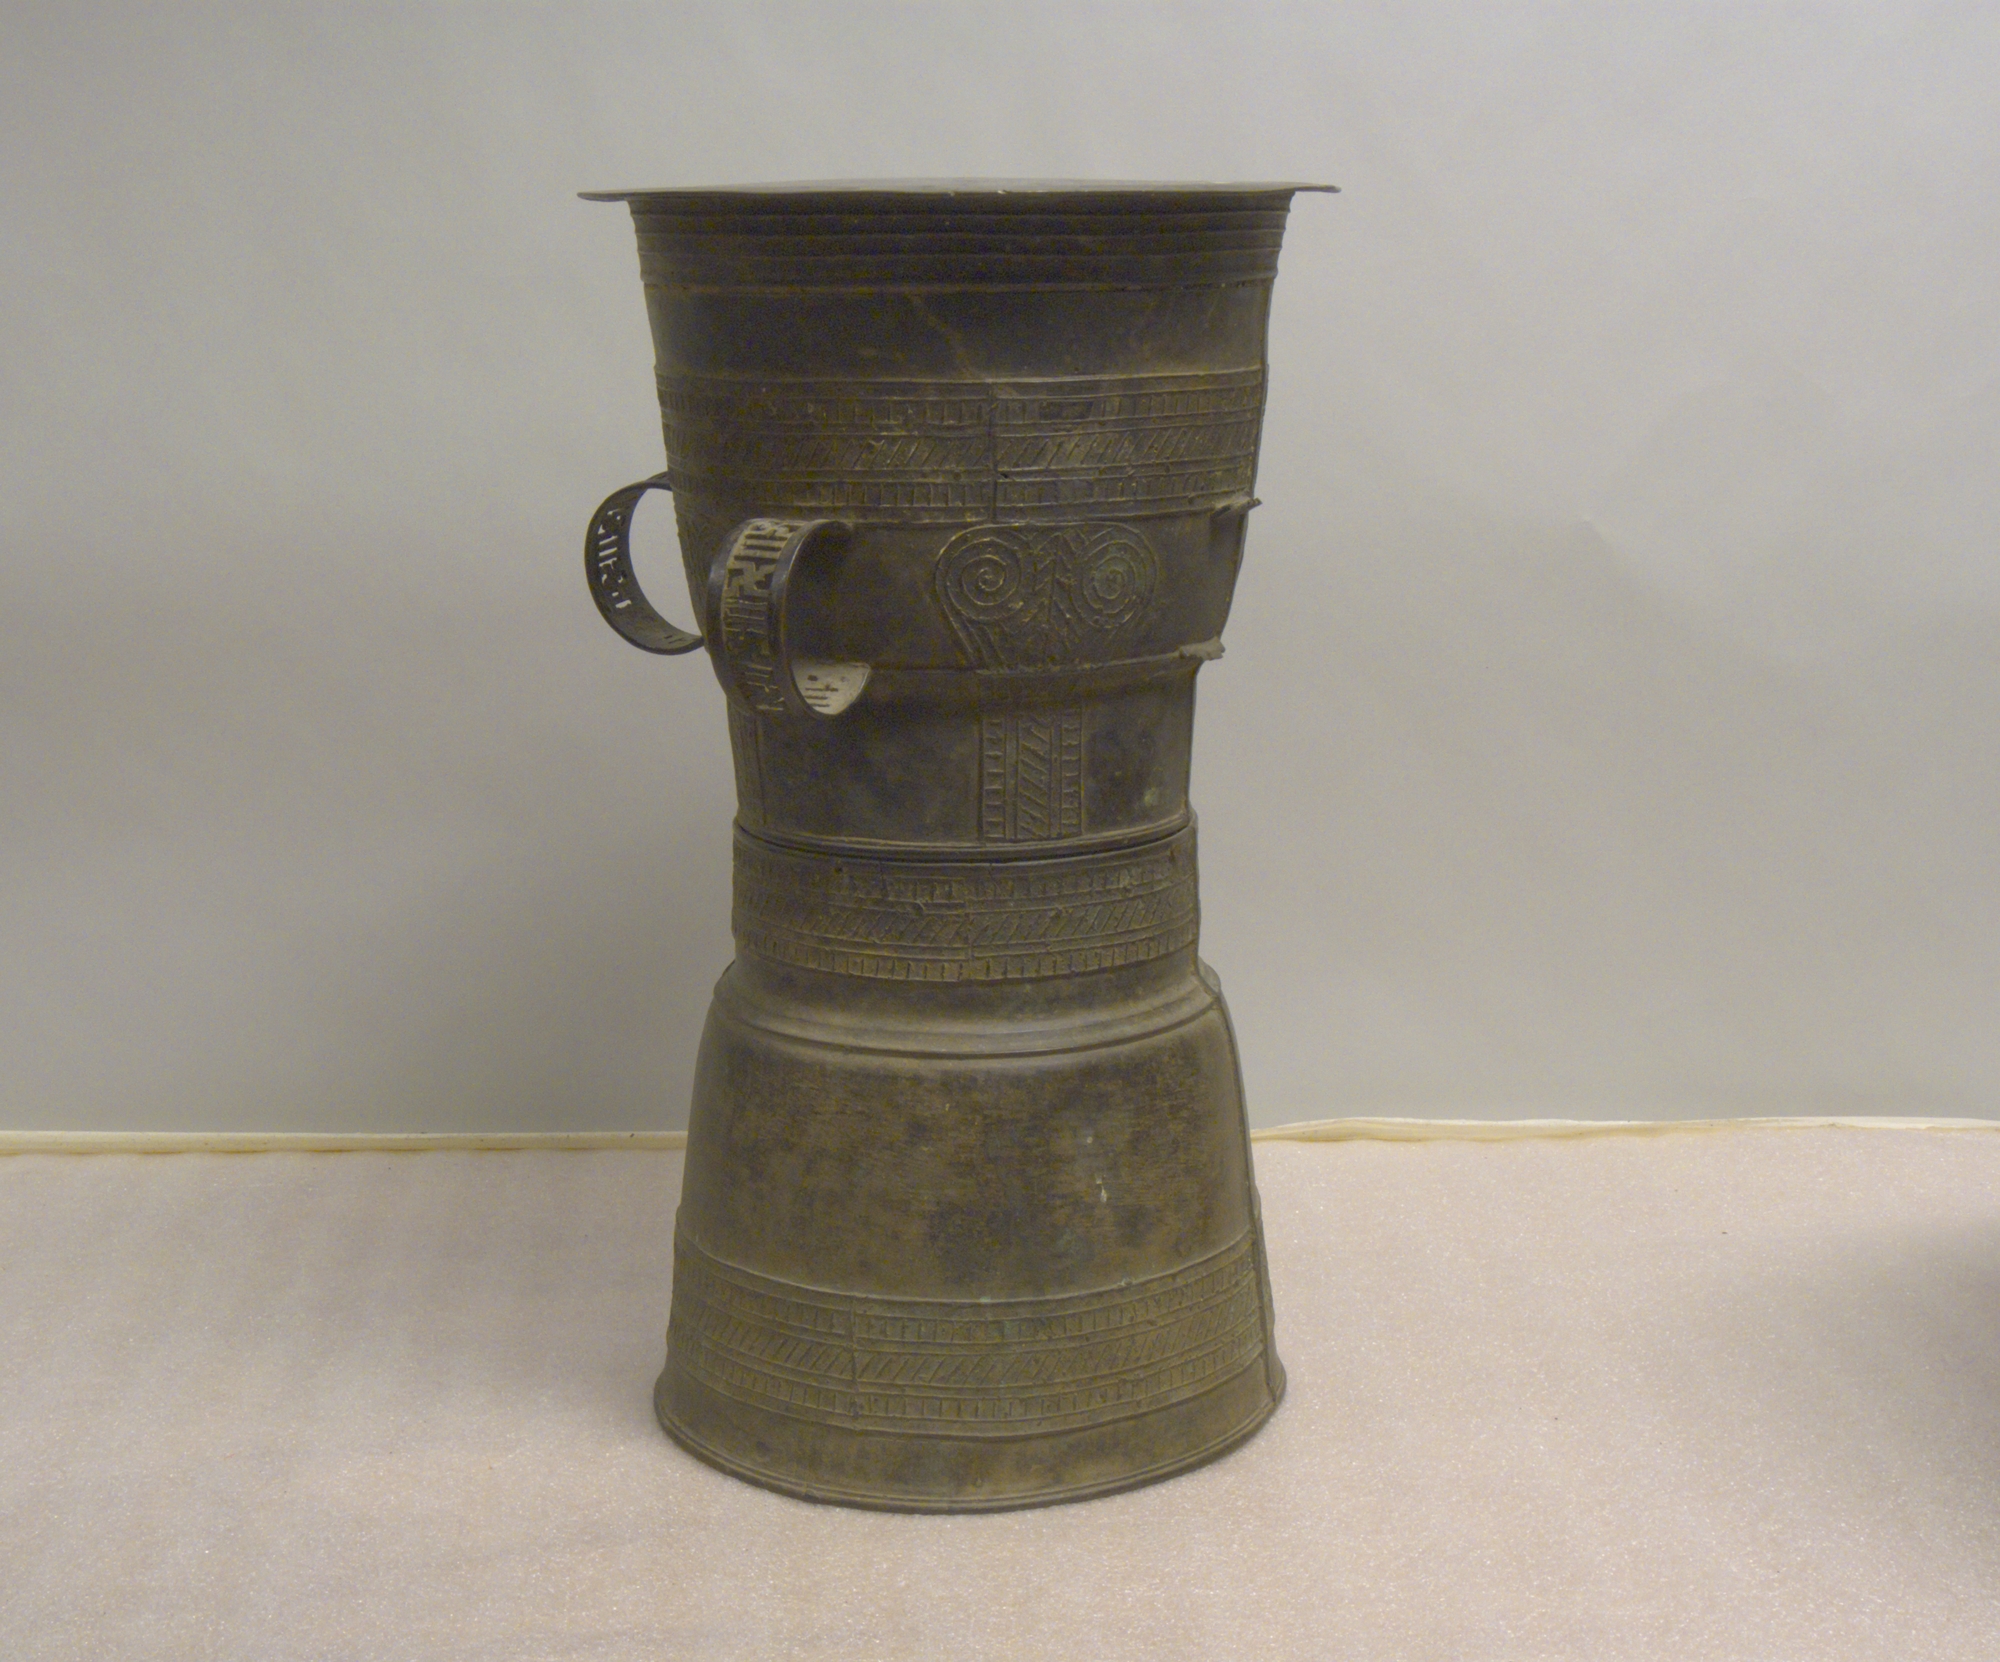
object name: drum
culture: indonesian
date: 500 BCE-300 CE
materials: bronze